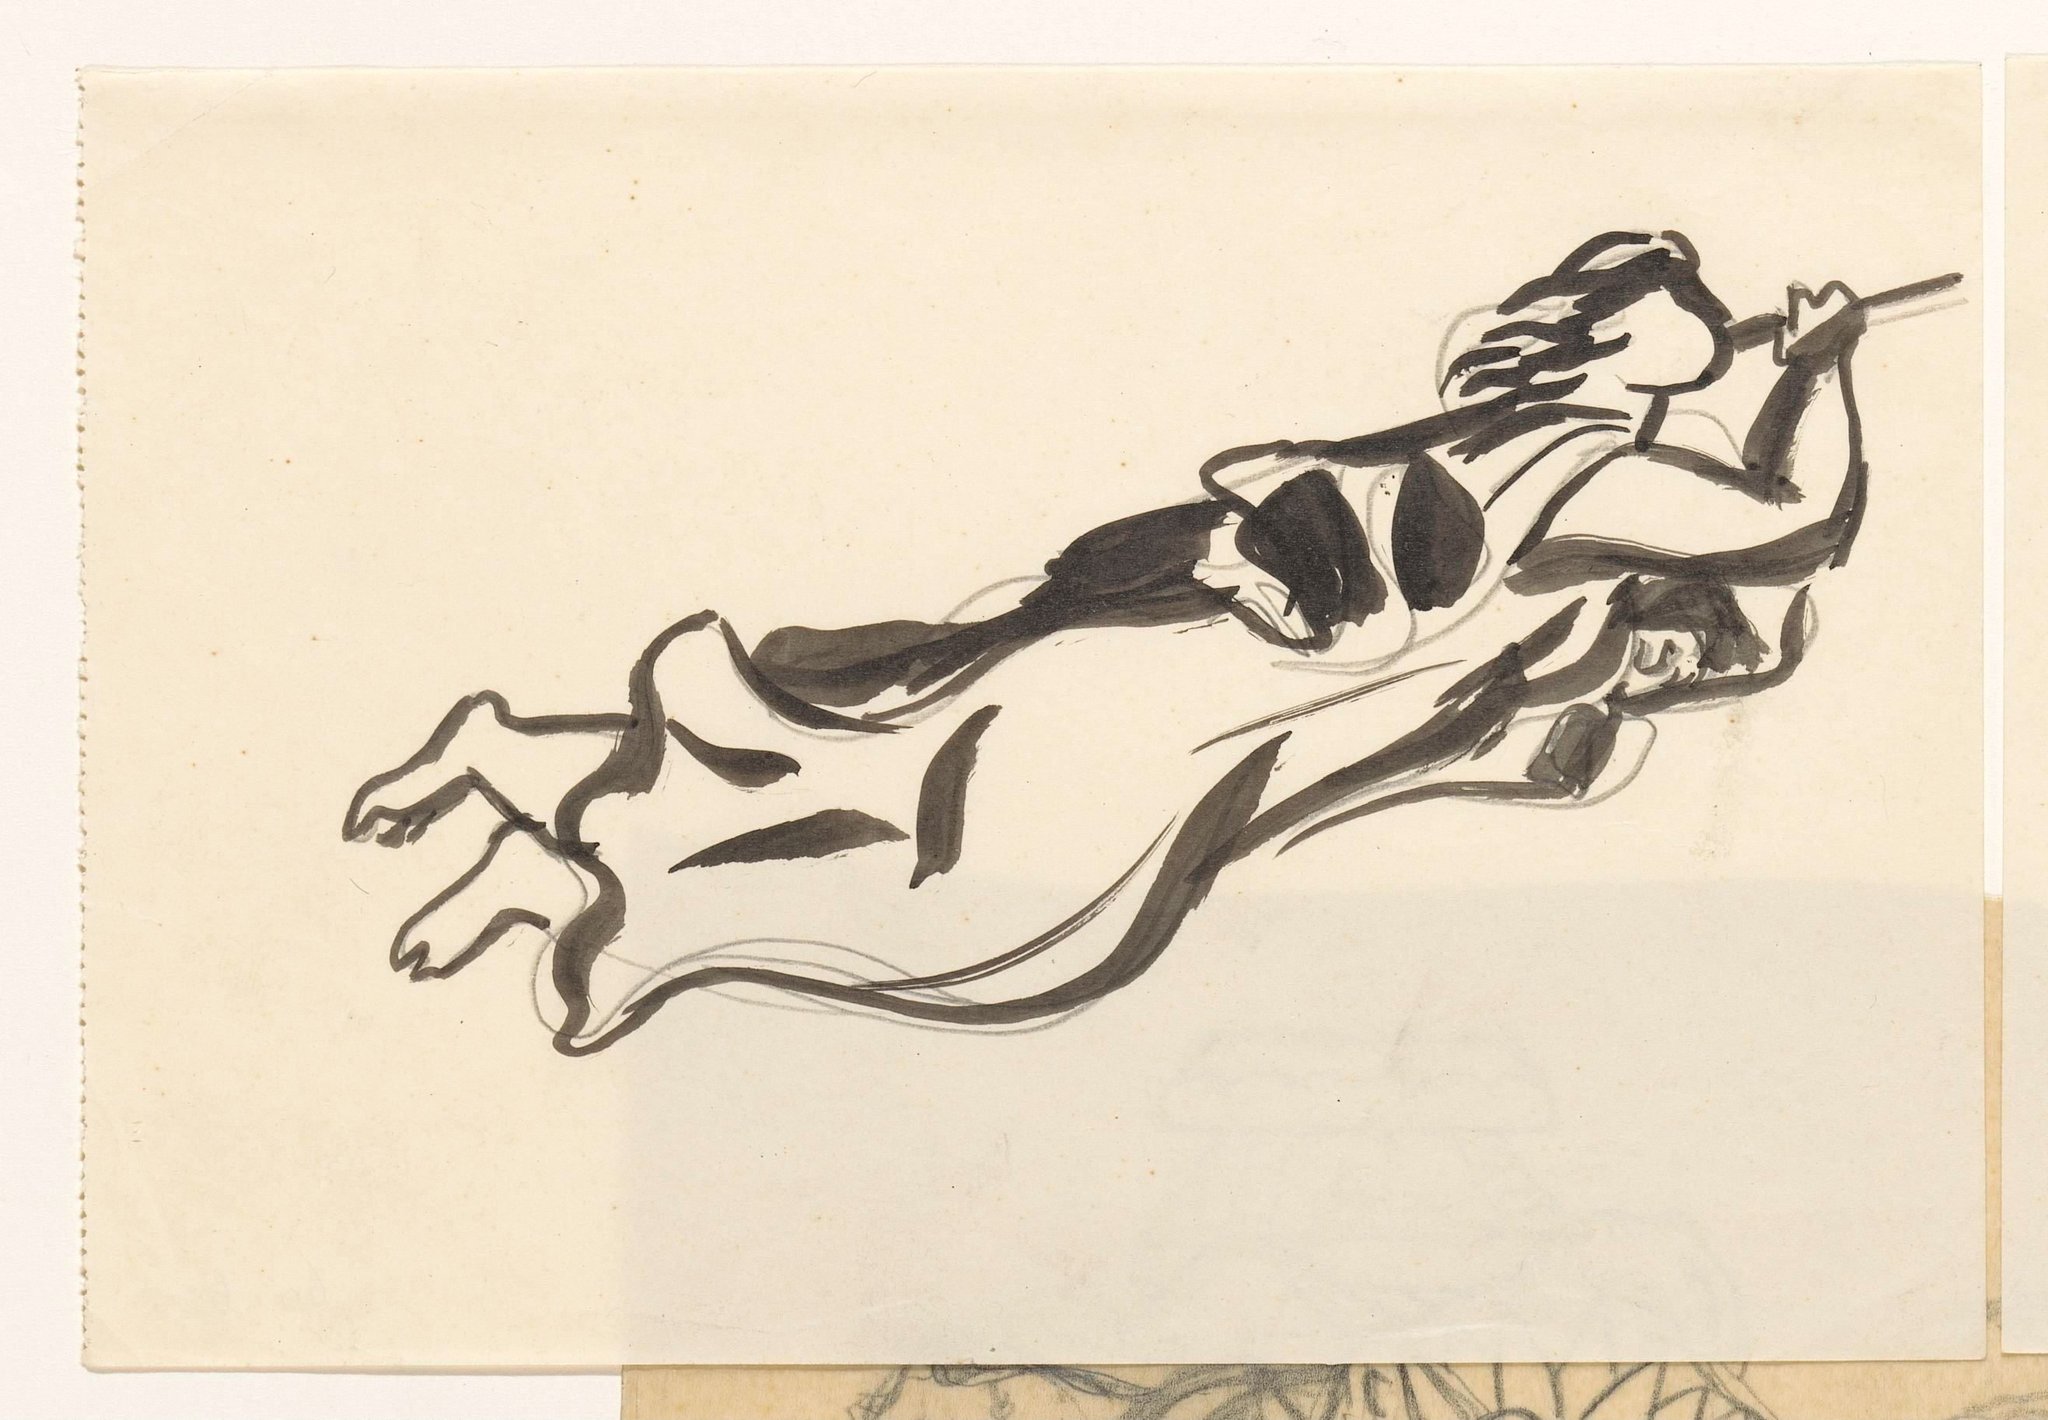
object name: drawing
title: Zwevende vrouw met trompet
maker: leo gestel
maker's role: draughtsman, print maker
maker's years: 1881-1941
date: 1891-1941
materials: paper, pencil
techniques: brush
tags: horn, trumpet, cornet, trombone, tuba, flying - aa - female human figure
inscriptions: collector's mark: Lugt 2228